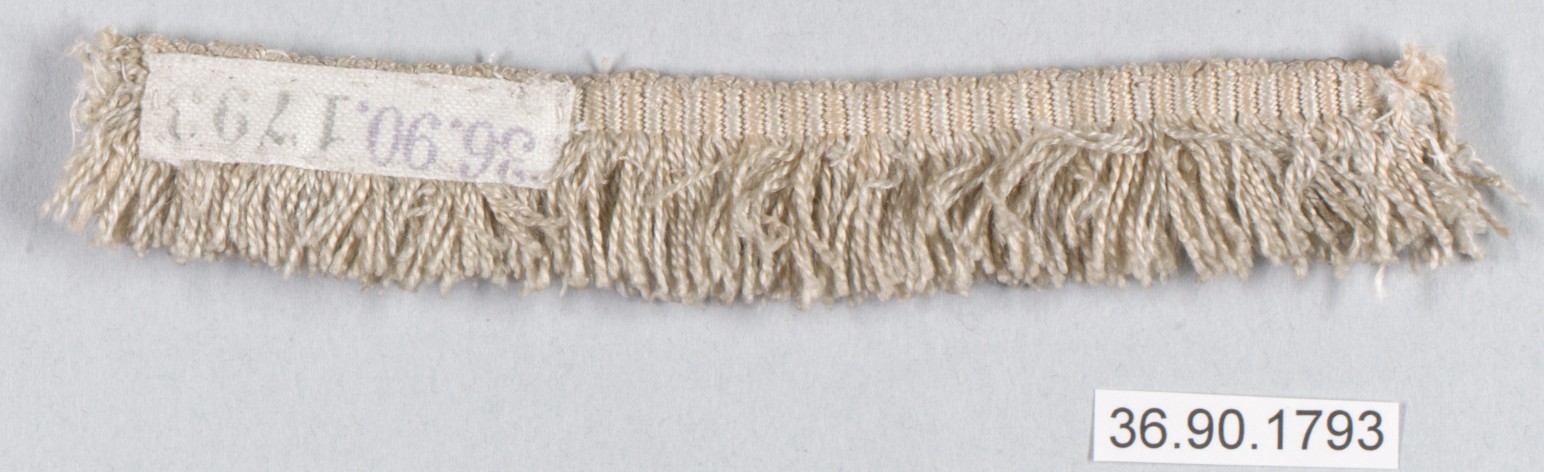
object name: fringe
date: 1834-1866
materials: silk